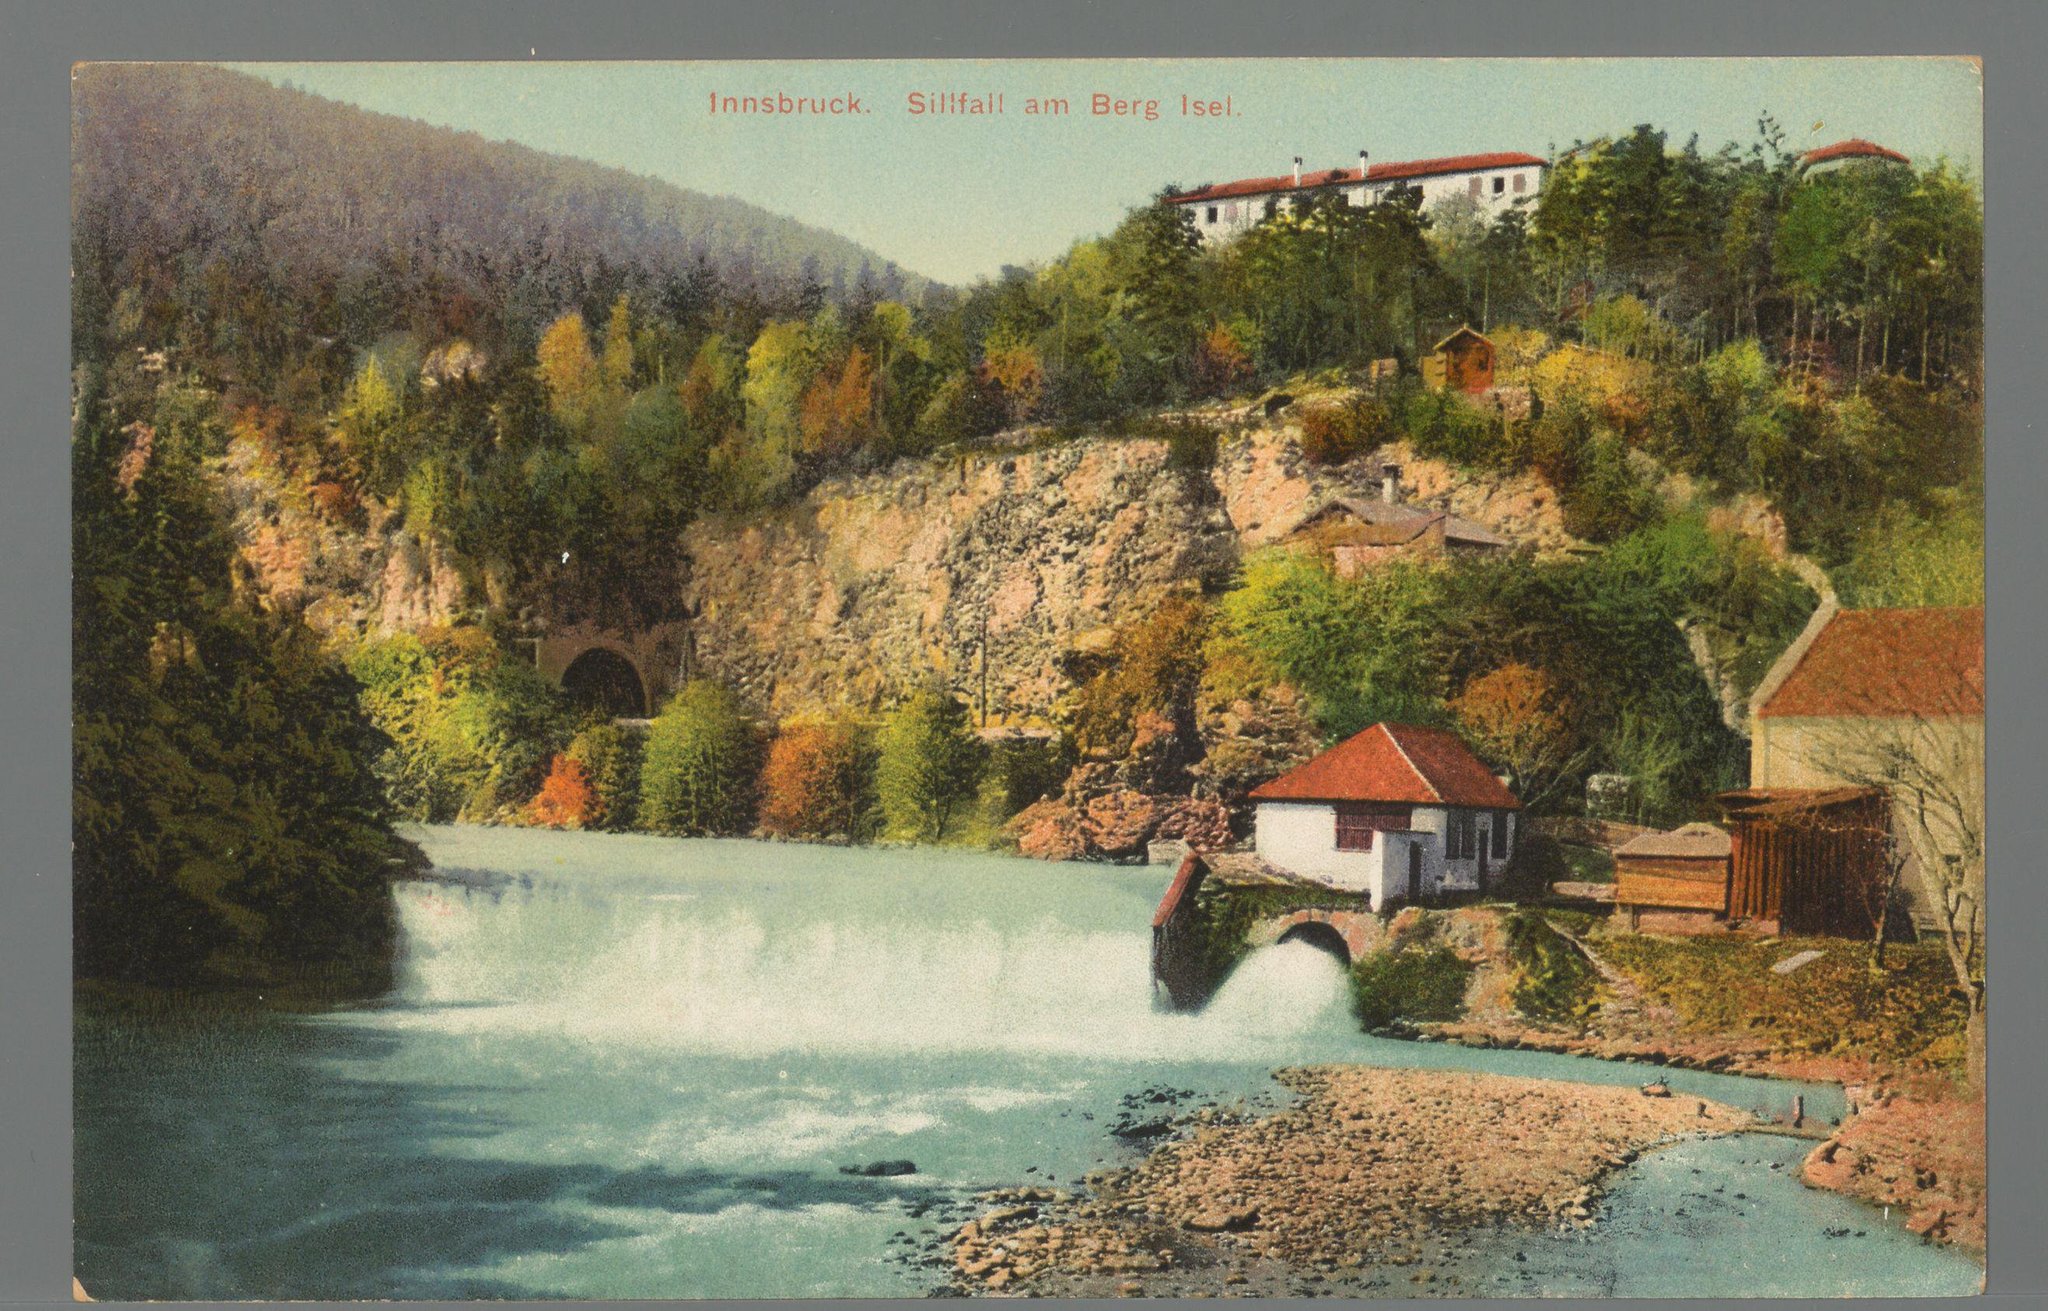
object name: ansichtkaart, prentbriefkaart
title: Innsbruck. Sillfall am Berg Isel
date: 1904-1930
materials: cardboard, photographic process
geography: bergisel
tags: river, (high) hill